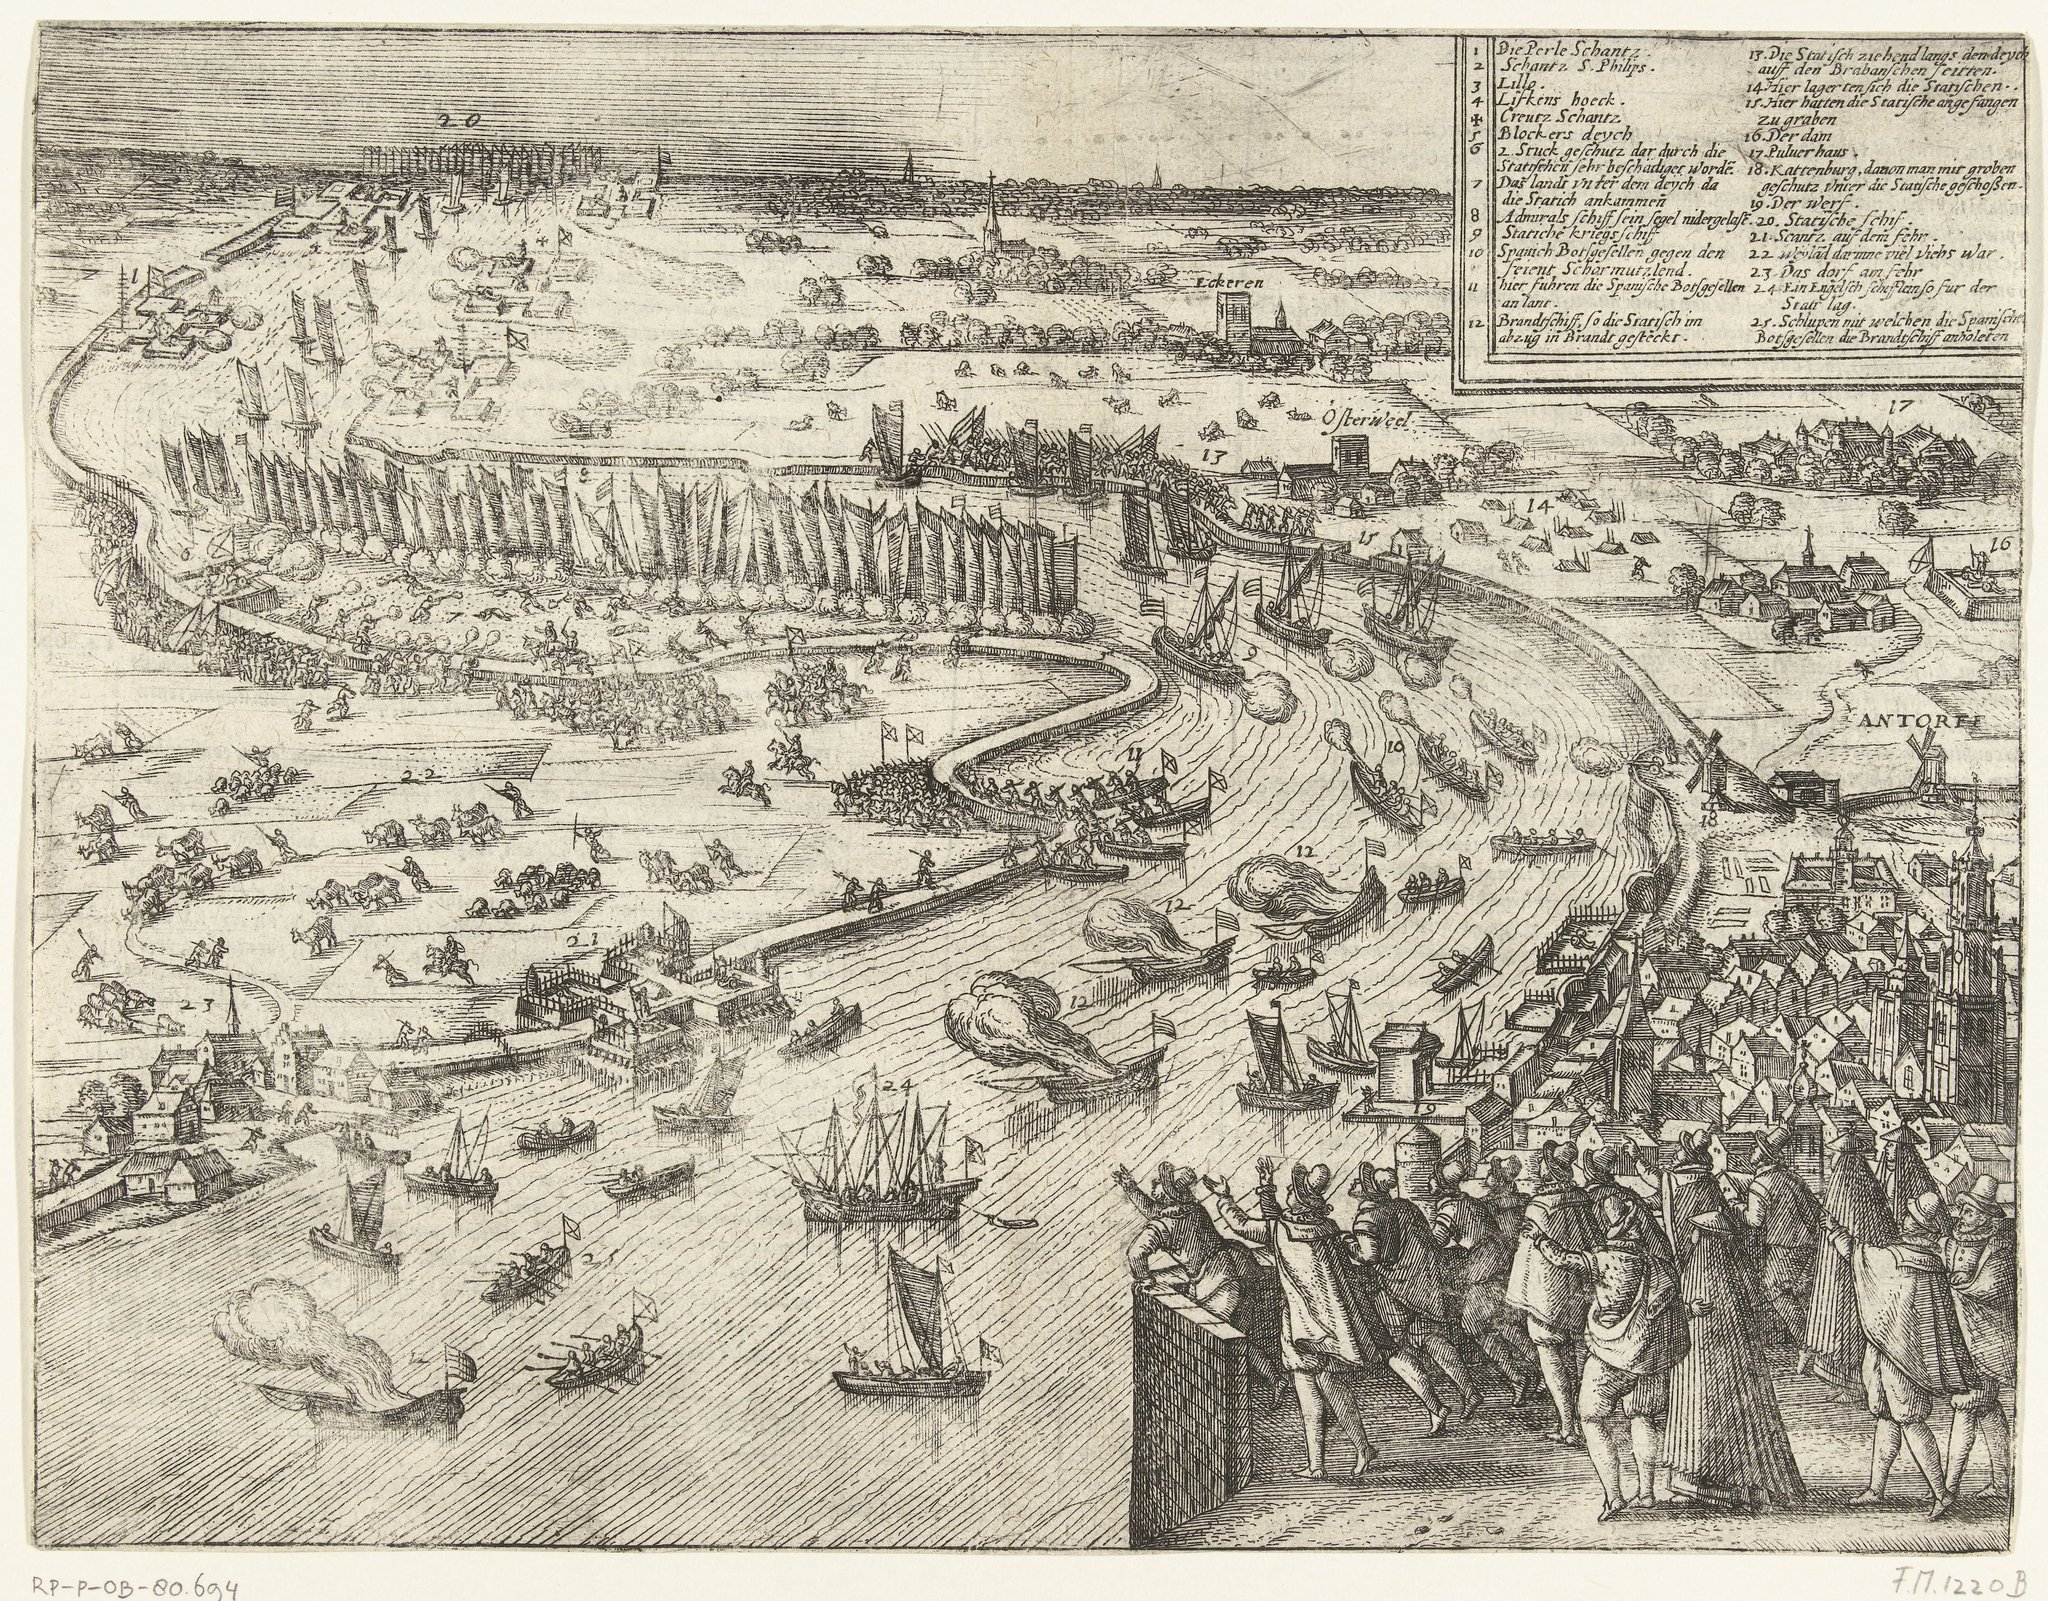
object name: print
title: Mislukte aanval op Antwerpen, 1605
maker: frans hogenberg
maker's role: print maker, publisher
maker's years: 1538-1590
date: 1605-1607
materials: paper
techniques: etching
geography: cologne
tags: ernst casimir graaf van nassau-dietz, battle, fighting in general, antwerp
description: Mislukte aanval door het Staatse leger op Antwerpen, 17 mei 1605. Gezicht vanuit de stad op de vloot van graaf Ernst Casimir van Nassau op de Schelde. Verschillende branders op het water, de schepen worden beschoten vanuit de forten. Linksboven zware gevechten bij de Blokkersdijk. Rechtsboven een cartouche met de legenda 1-25 in het Duits. Bedrukt op achterzijde met tekst in het Latijn.